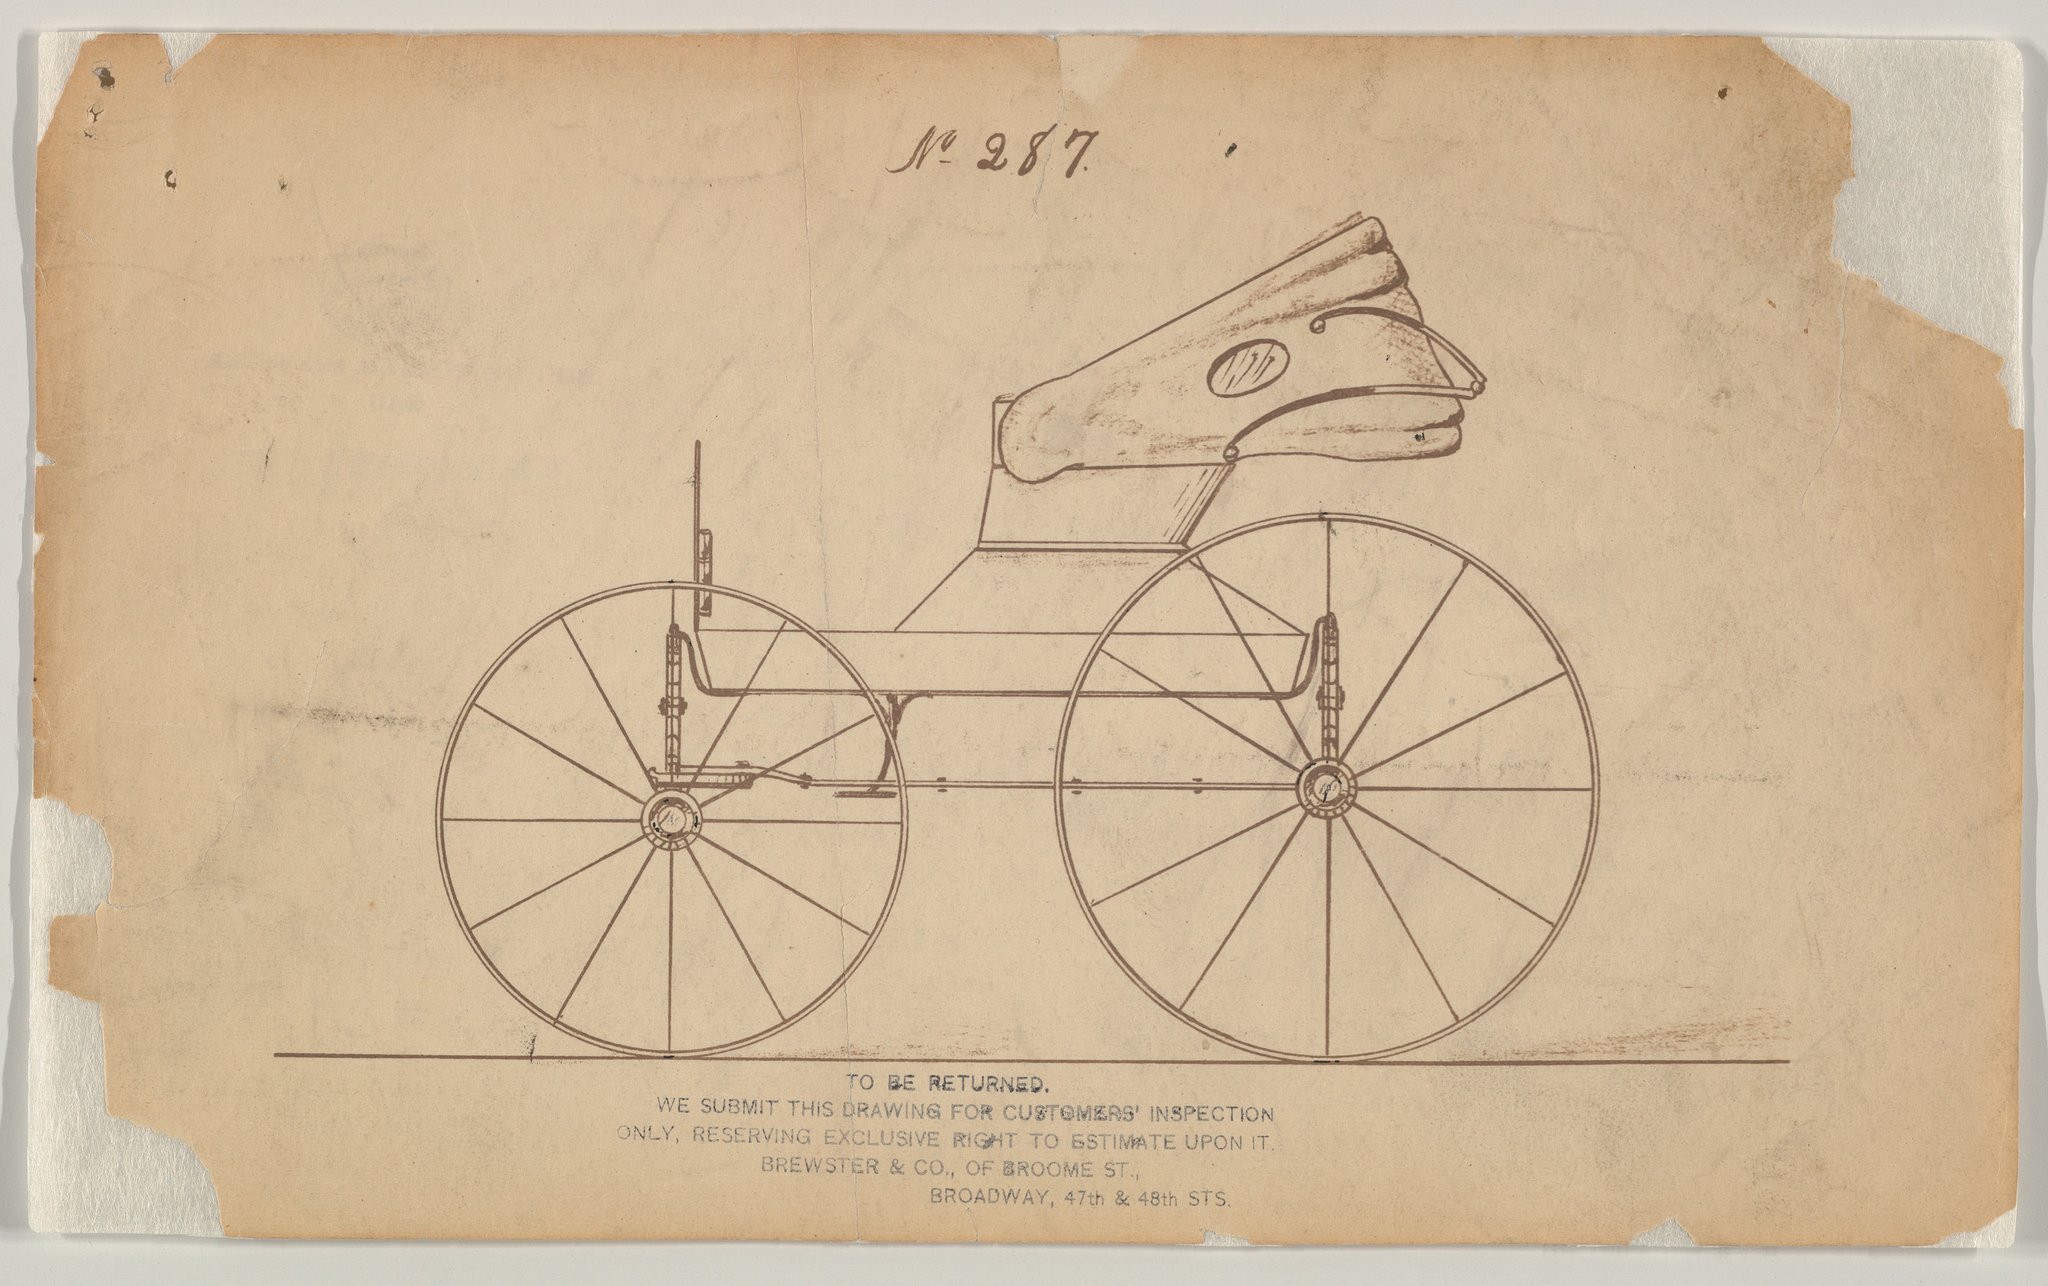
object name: drawing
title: Design for Road Wagon with Folding Top, no. 287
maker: brewster & co.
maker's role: manufacturer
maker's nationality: american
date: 1875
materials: ink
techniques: pen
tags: carriages